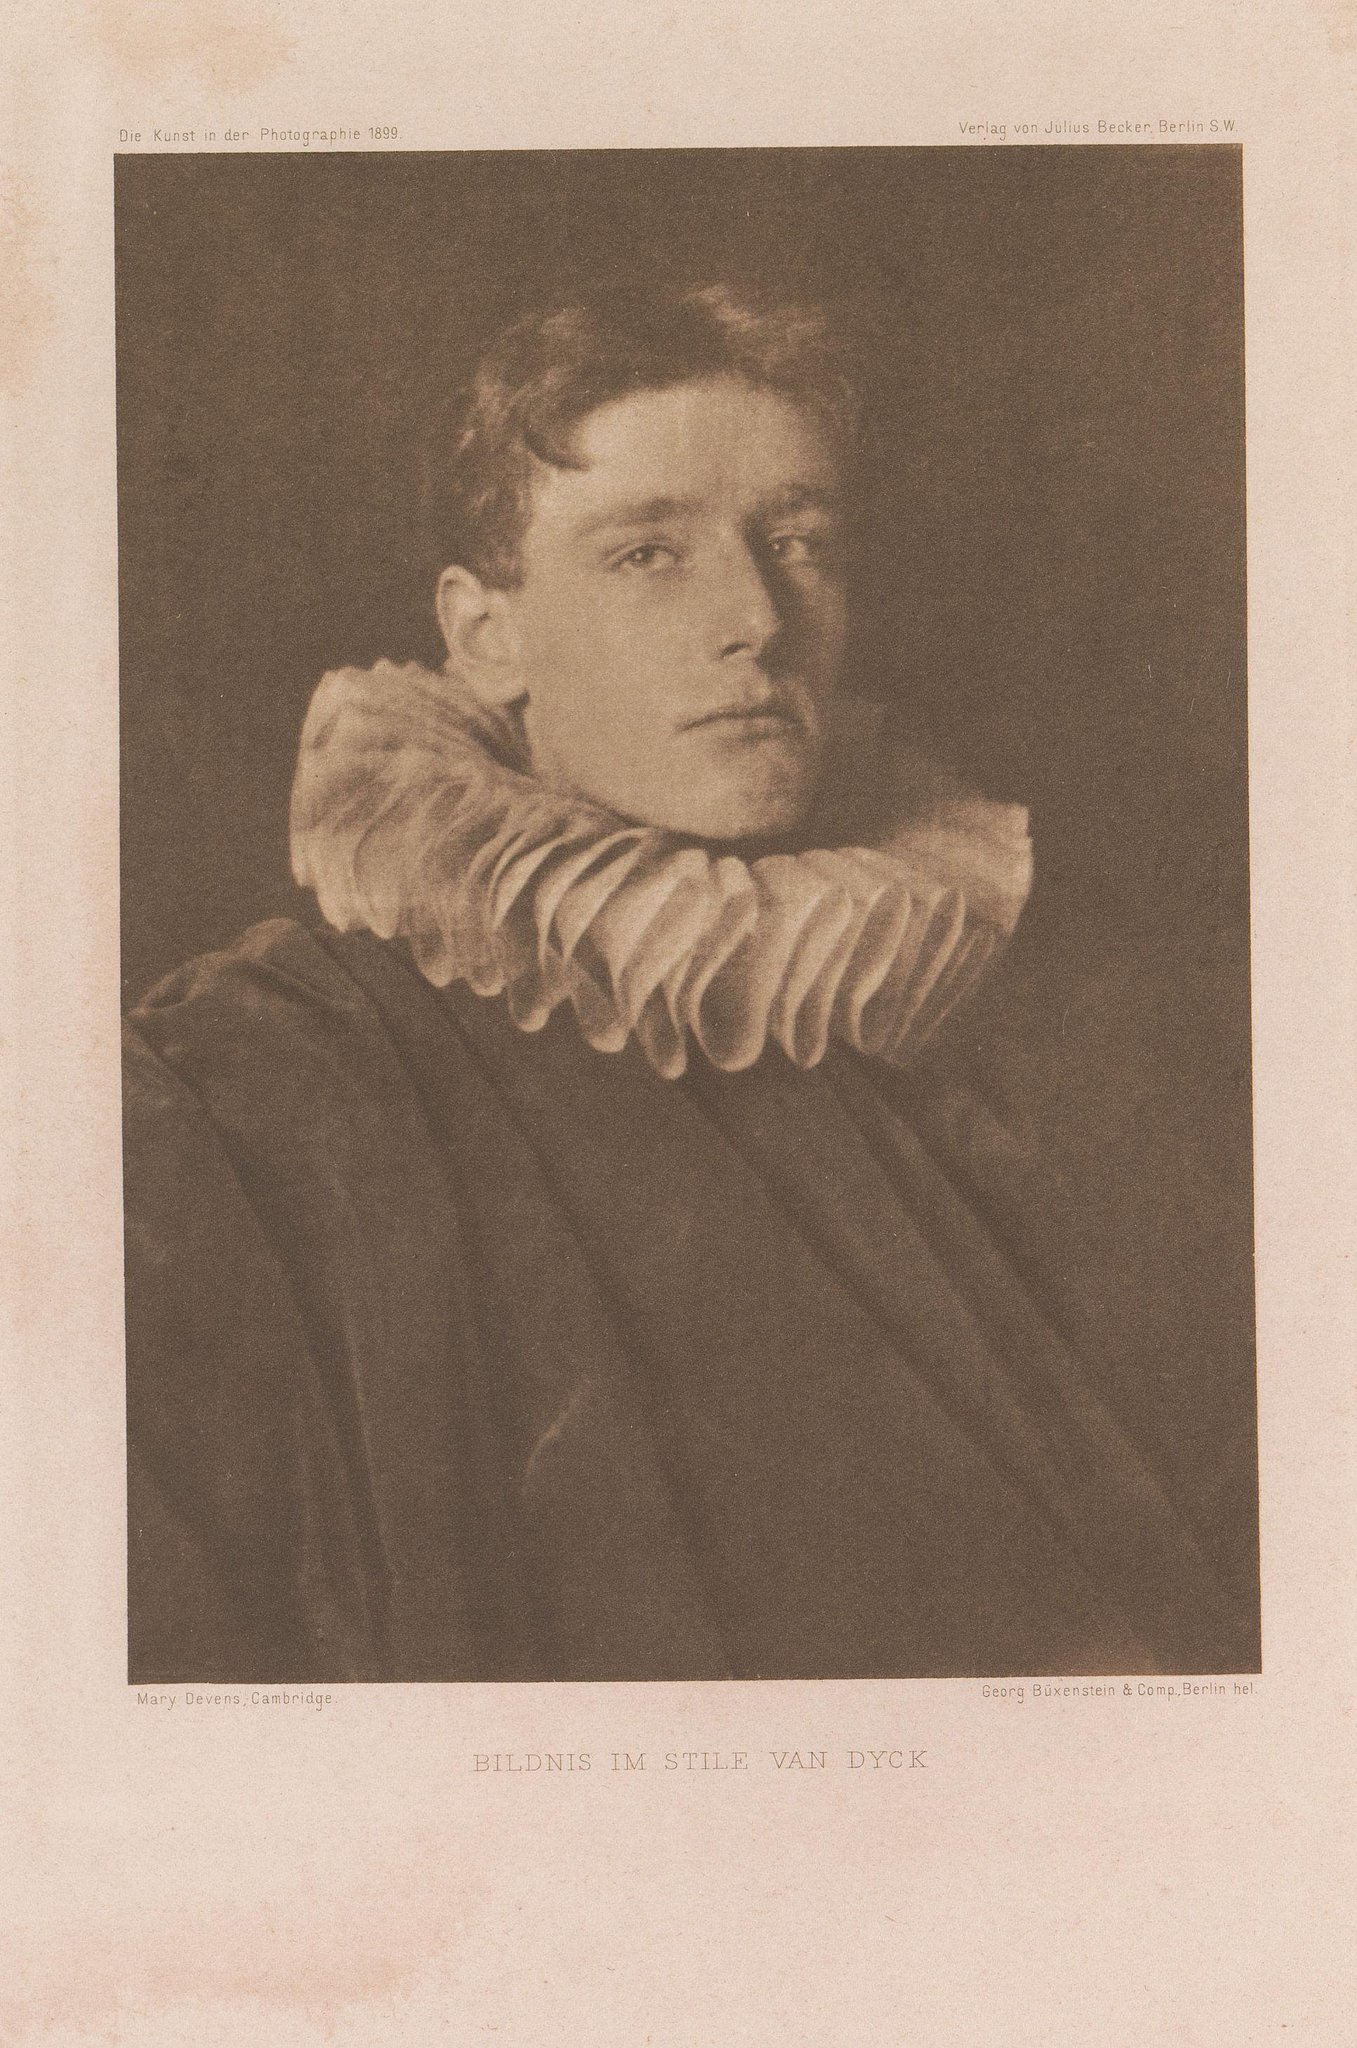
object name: page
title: Bildnis im Stile Van Dyck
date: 1889-1899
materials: paper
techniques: photoaquatint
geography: berlin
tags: anonymous historical person portrayed, neck-gear: collar